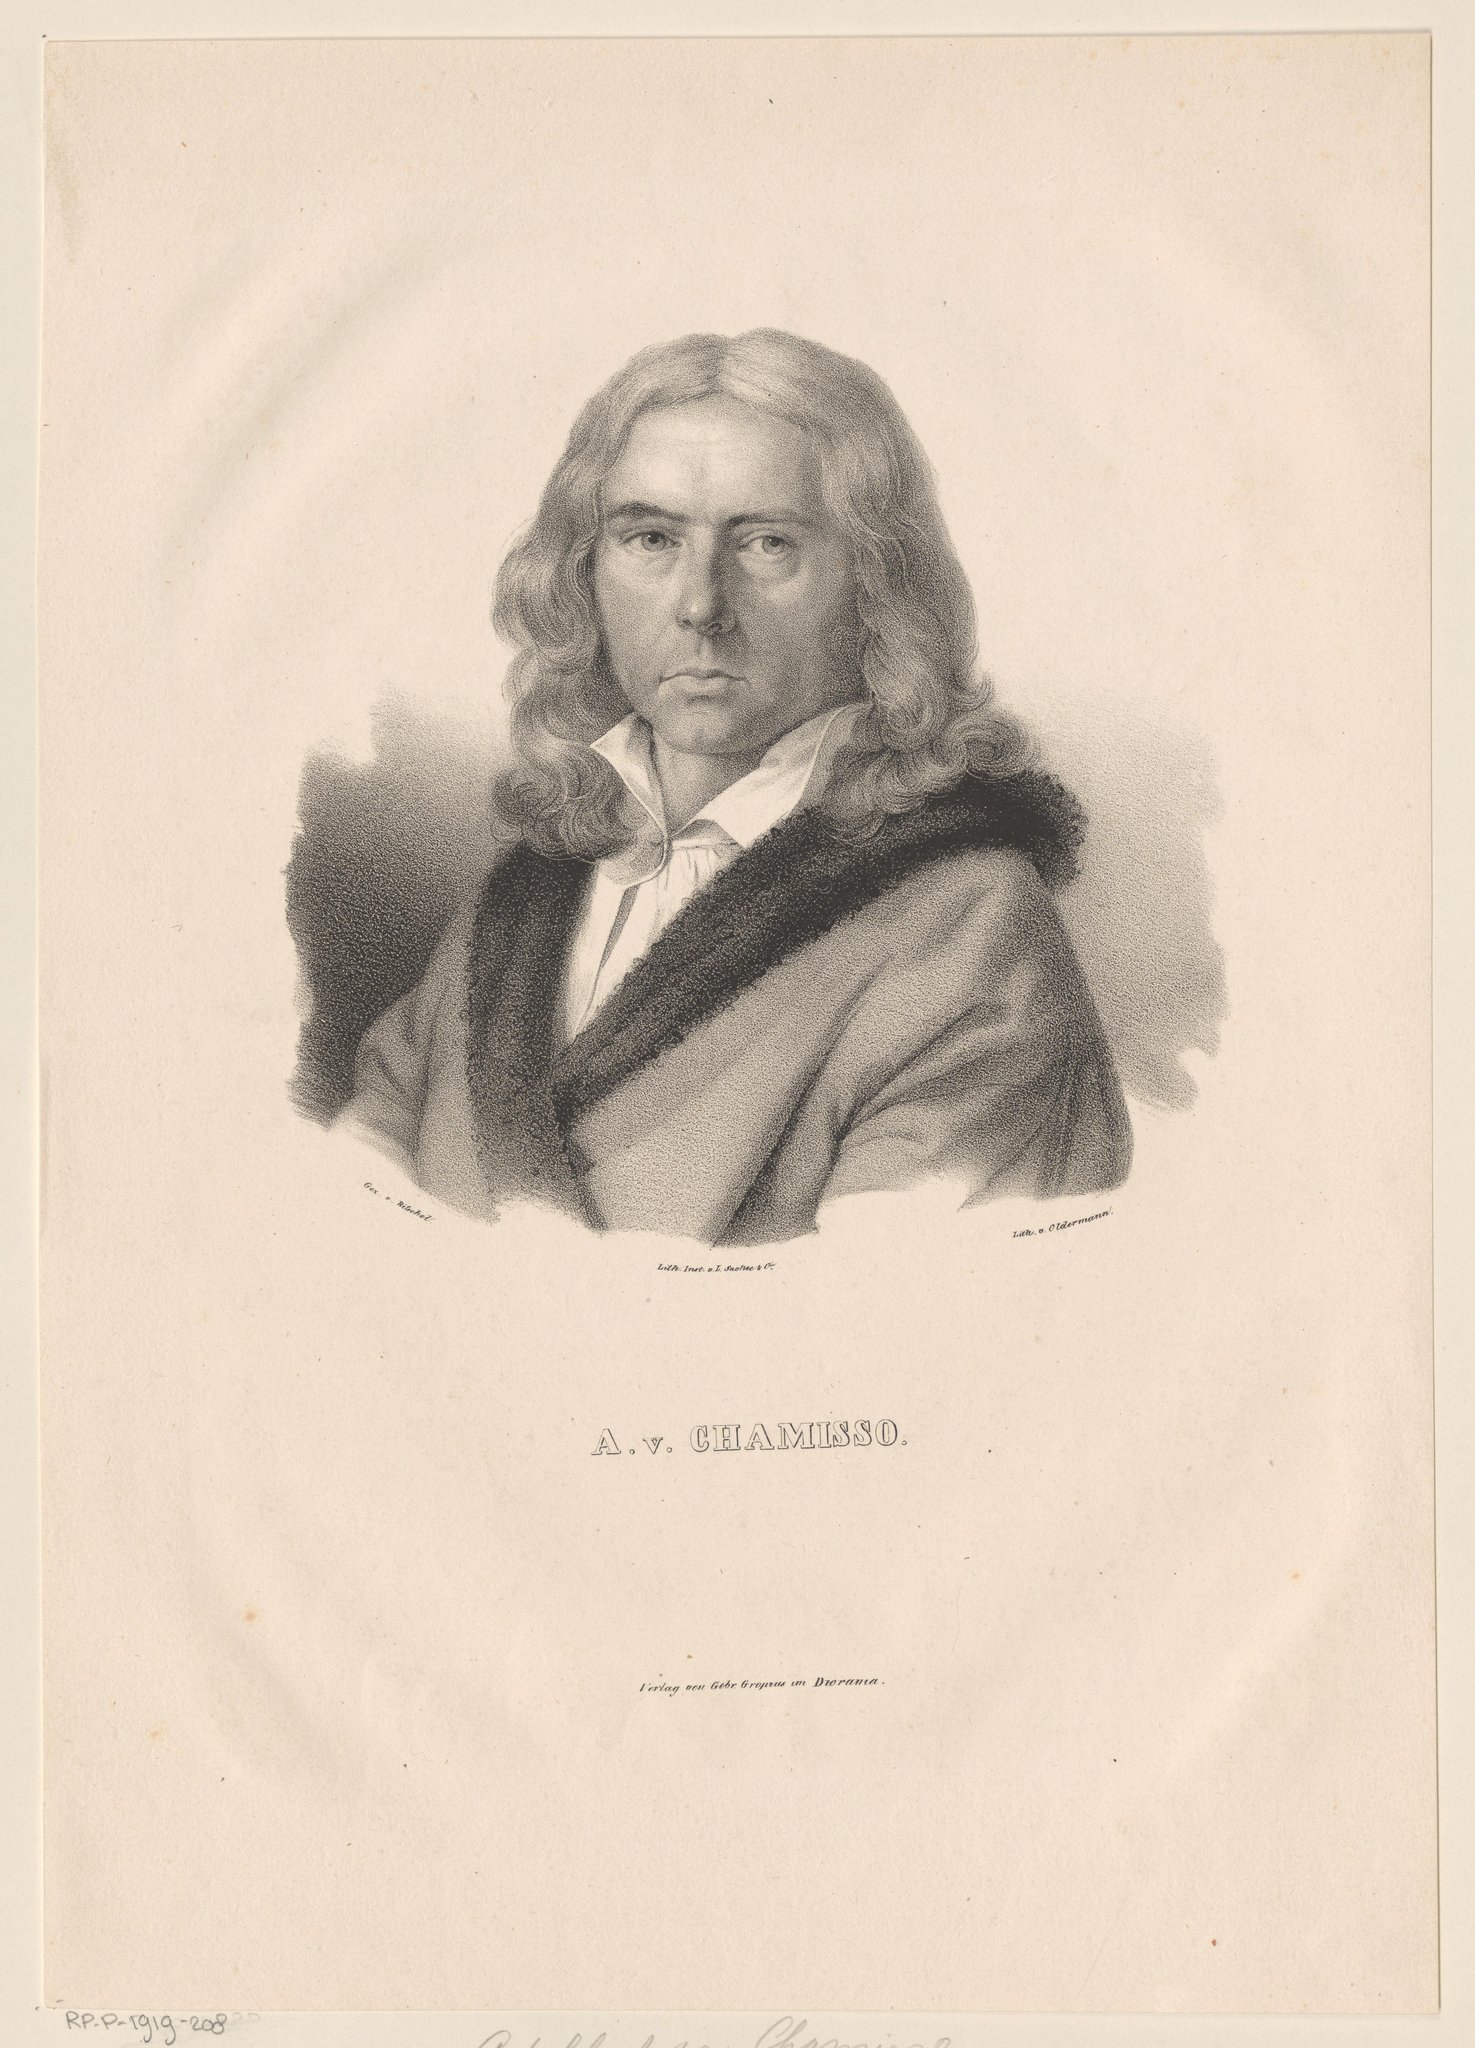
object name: print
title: Portret van Adelbert von Chamisso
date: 1832-1854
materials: paper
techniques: lithograph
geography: berlin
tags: berlin, adelbert von chamisso, historical persons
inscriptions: collector's mark: Lugt 2282